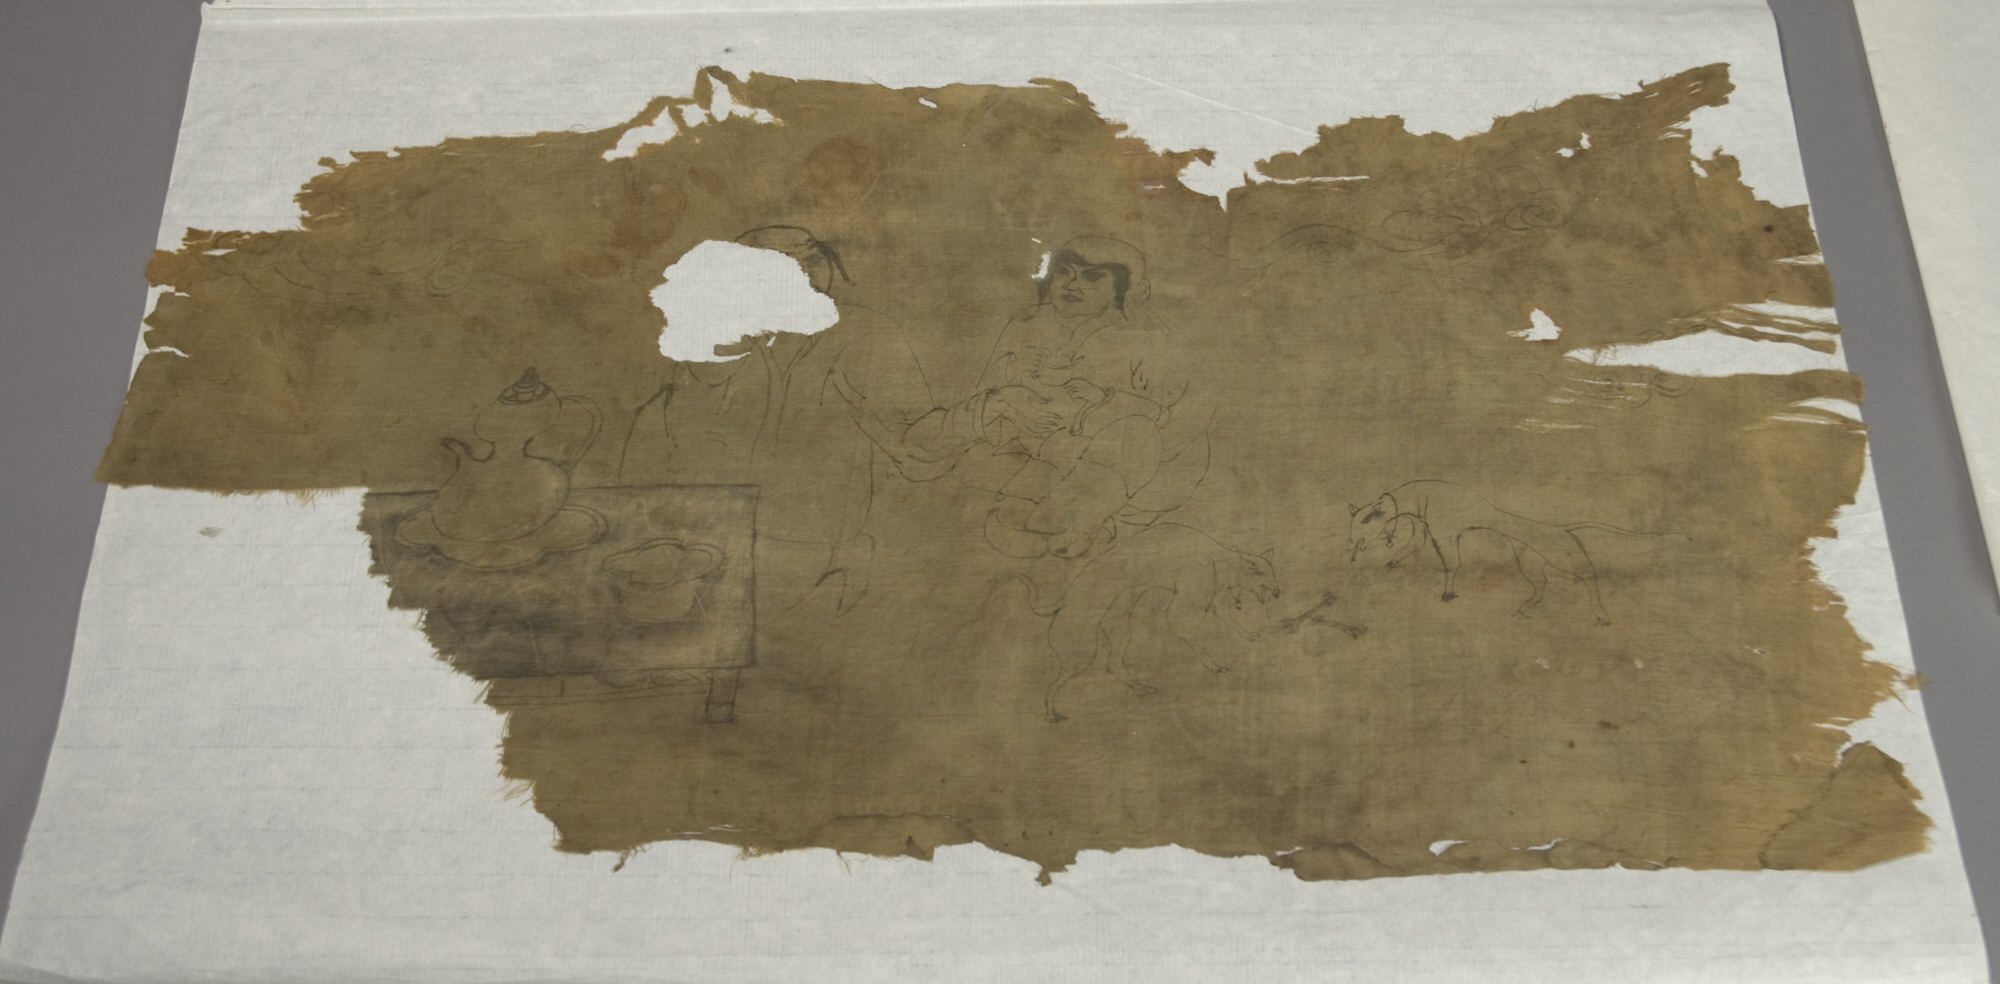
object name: fragment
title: Banquet Scene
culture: chinese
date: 907-1125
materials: ink, silk